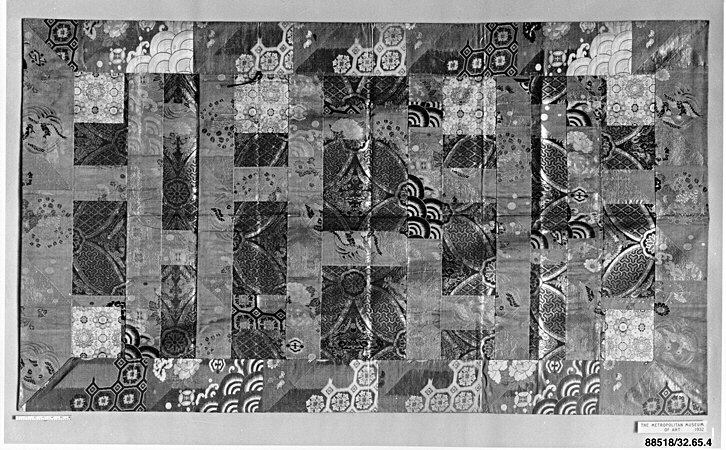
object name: robe, priest's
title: Priest's Robe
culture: japanese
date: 1801-1900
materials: metal thread, silk